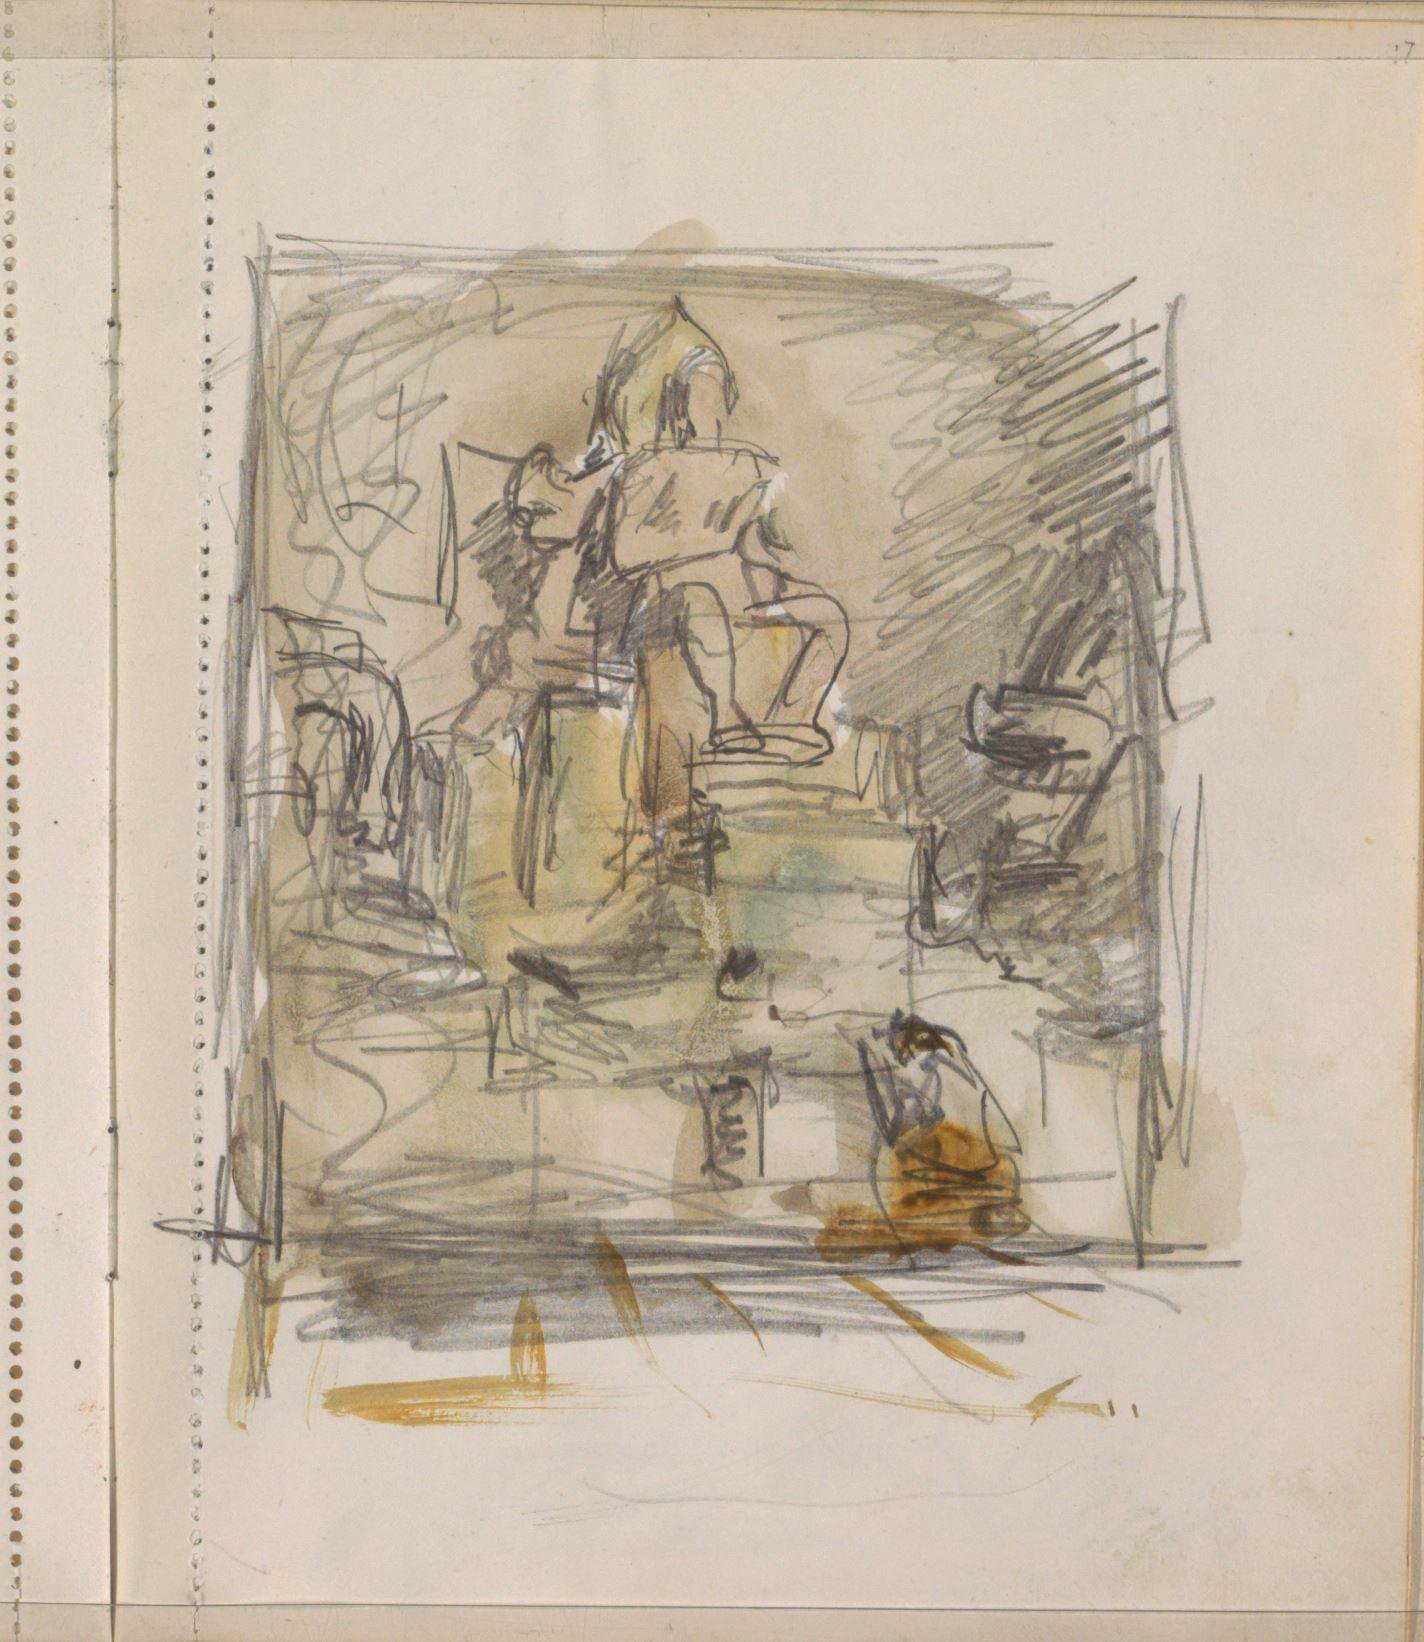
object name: sketchbook leaf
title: Knielende figuur in het interieur van de Mendoet Tempel op Java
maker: marius bauer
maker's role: draughtsman, print maker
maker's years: 1867-1932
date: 1925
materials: paper, pencil, watercolor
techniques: brush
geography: java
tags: temple, shrine ~ hinduism, buddhism, jainism, kneeling figure, interior ~ representation of a building, statues, paintings, etc. ~ objects of worship (hinduism, buddhism, jainism)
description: Pagina 17 uit een schetsboek met 67 bladen.